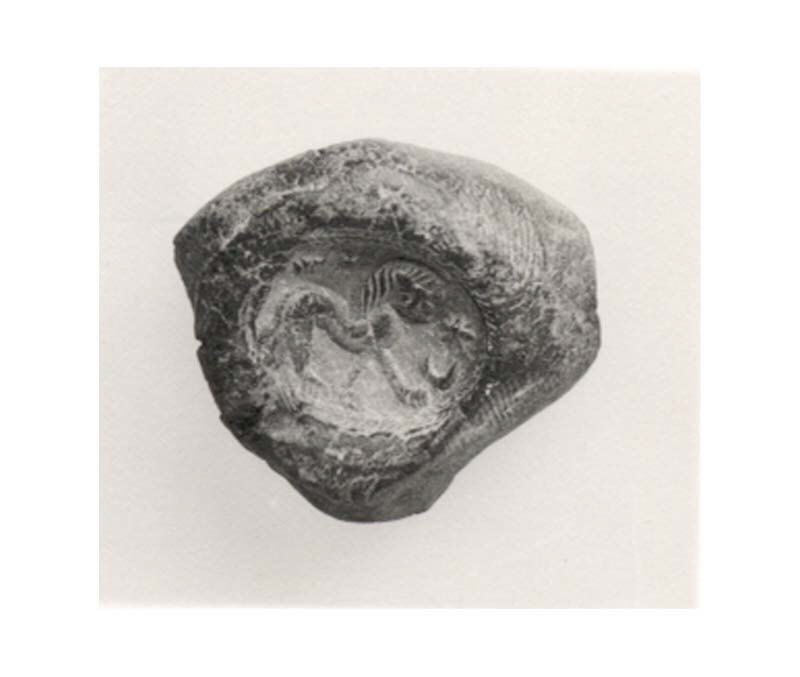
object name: sealing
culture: sasanian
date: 601-700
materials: clay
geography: iran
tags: animals